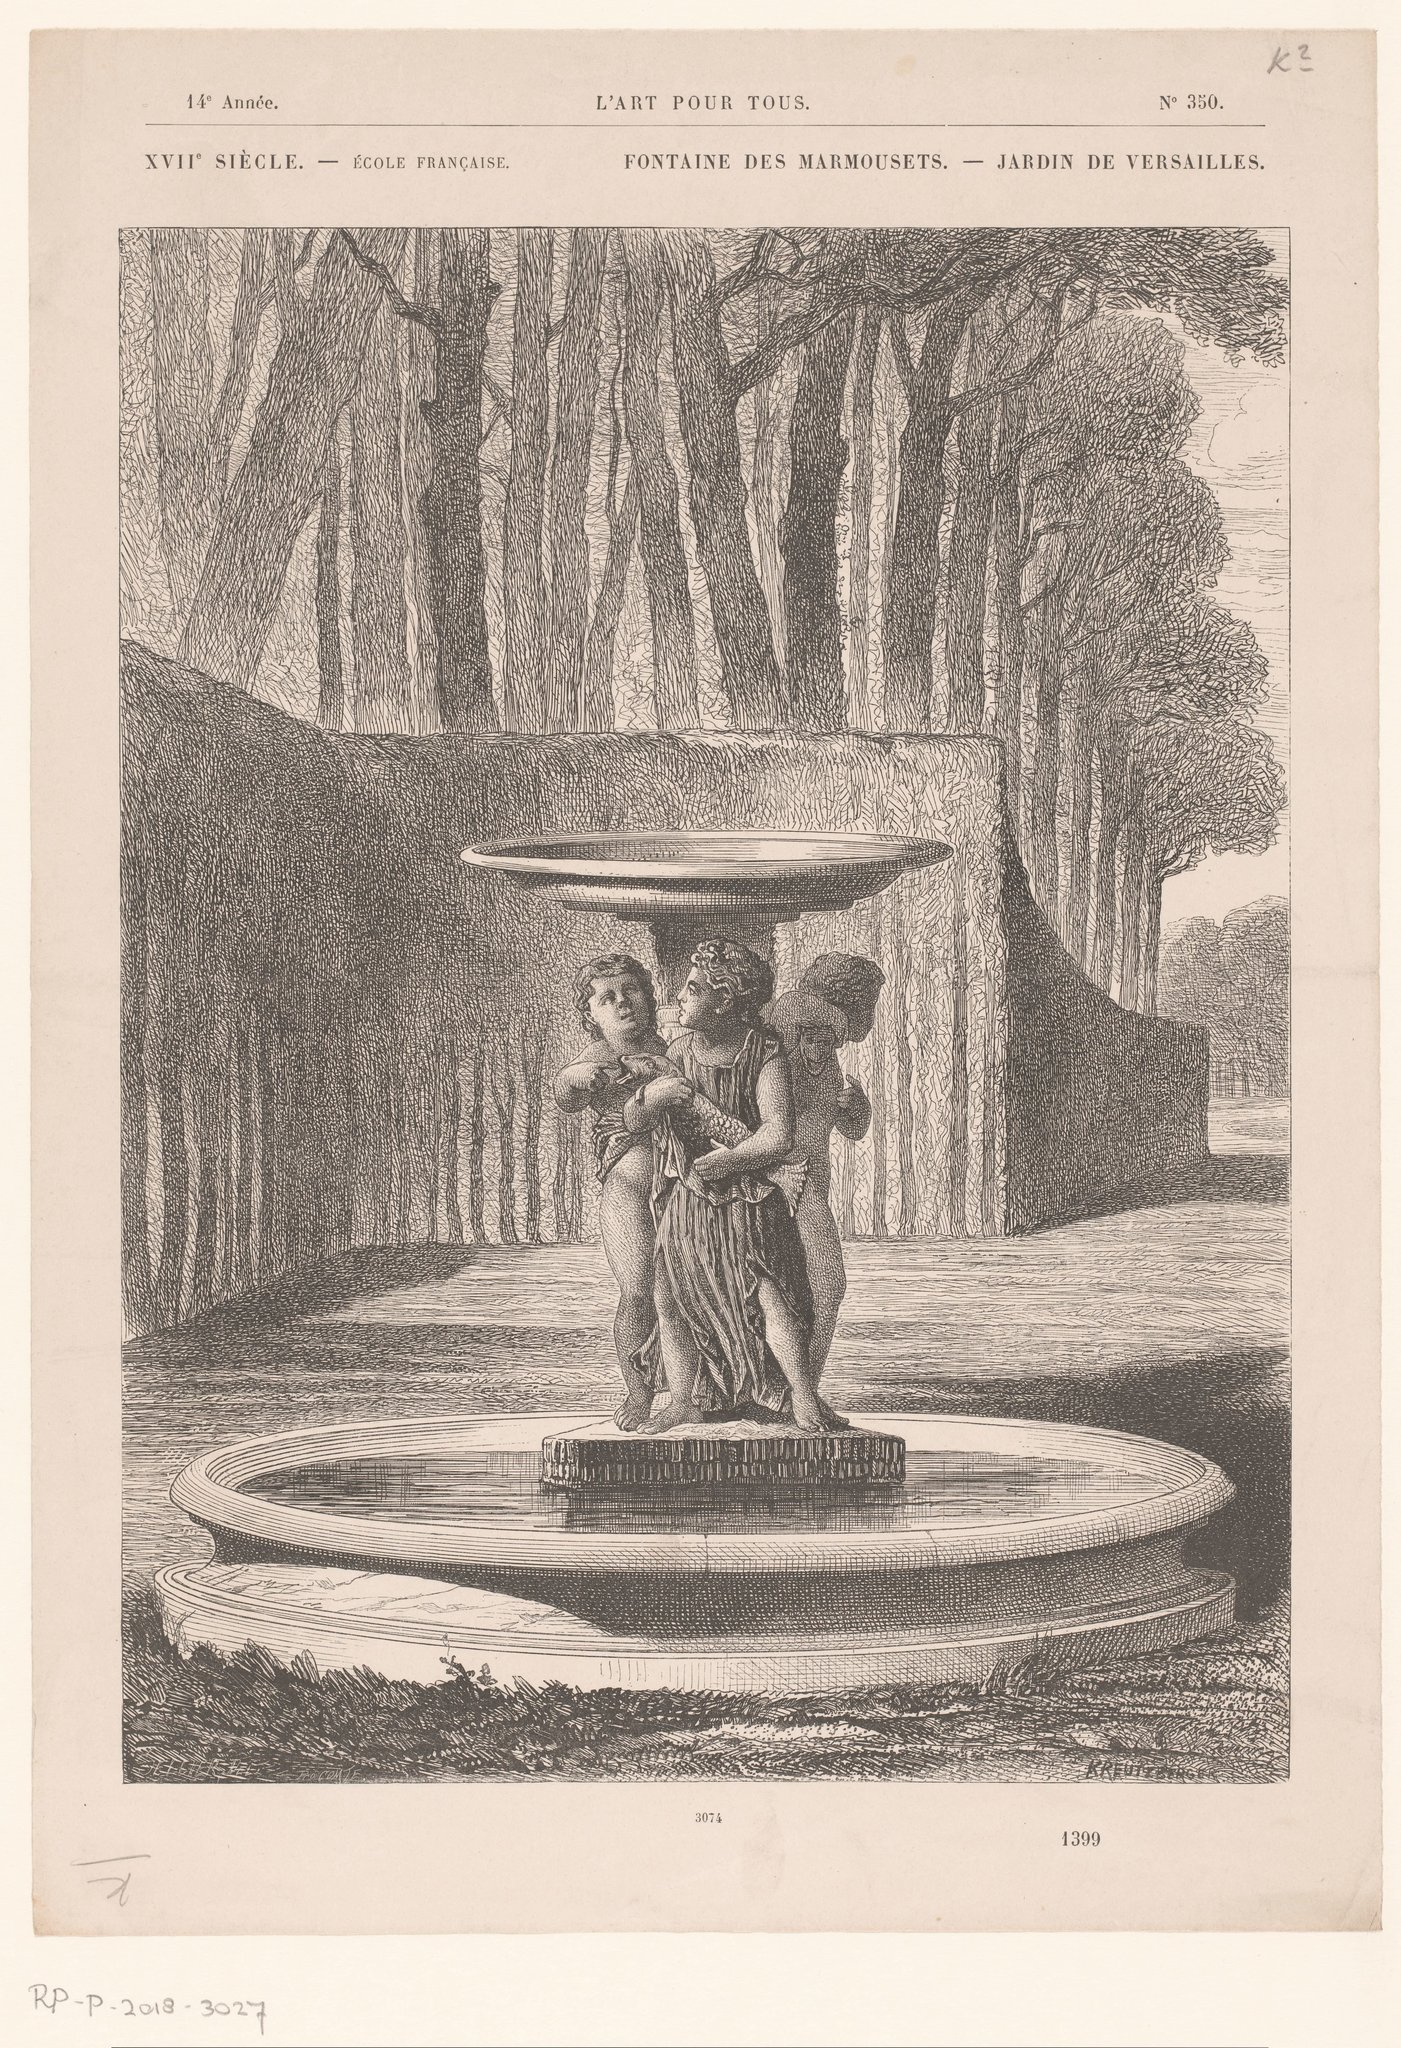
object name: print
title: Fontein met kinderfiguren, een daarvan met een vis in de armen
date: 1875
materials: paper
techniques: lithograph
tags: statues, sculptures in garden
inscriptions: collector's mark: Lugt 3937, collector's mark: Lugt 2228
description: Prent uit: Sauvageot (ed.). L'Art Pour Tous, encyclopédie de l'art industriel et decoratif (1875). Nr. 350.